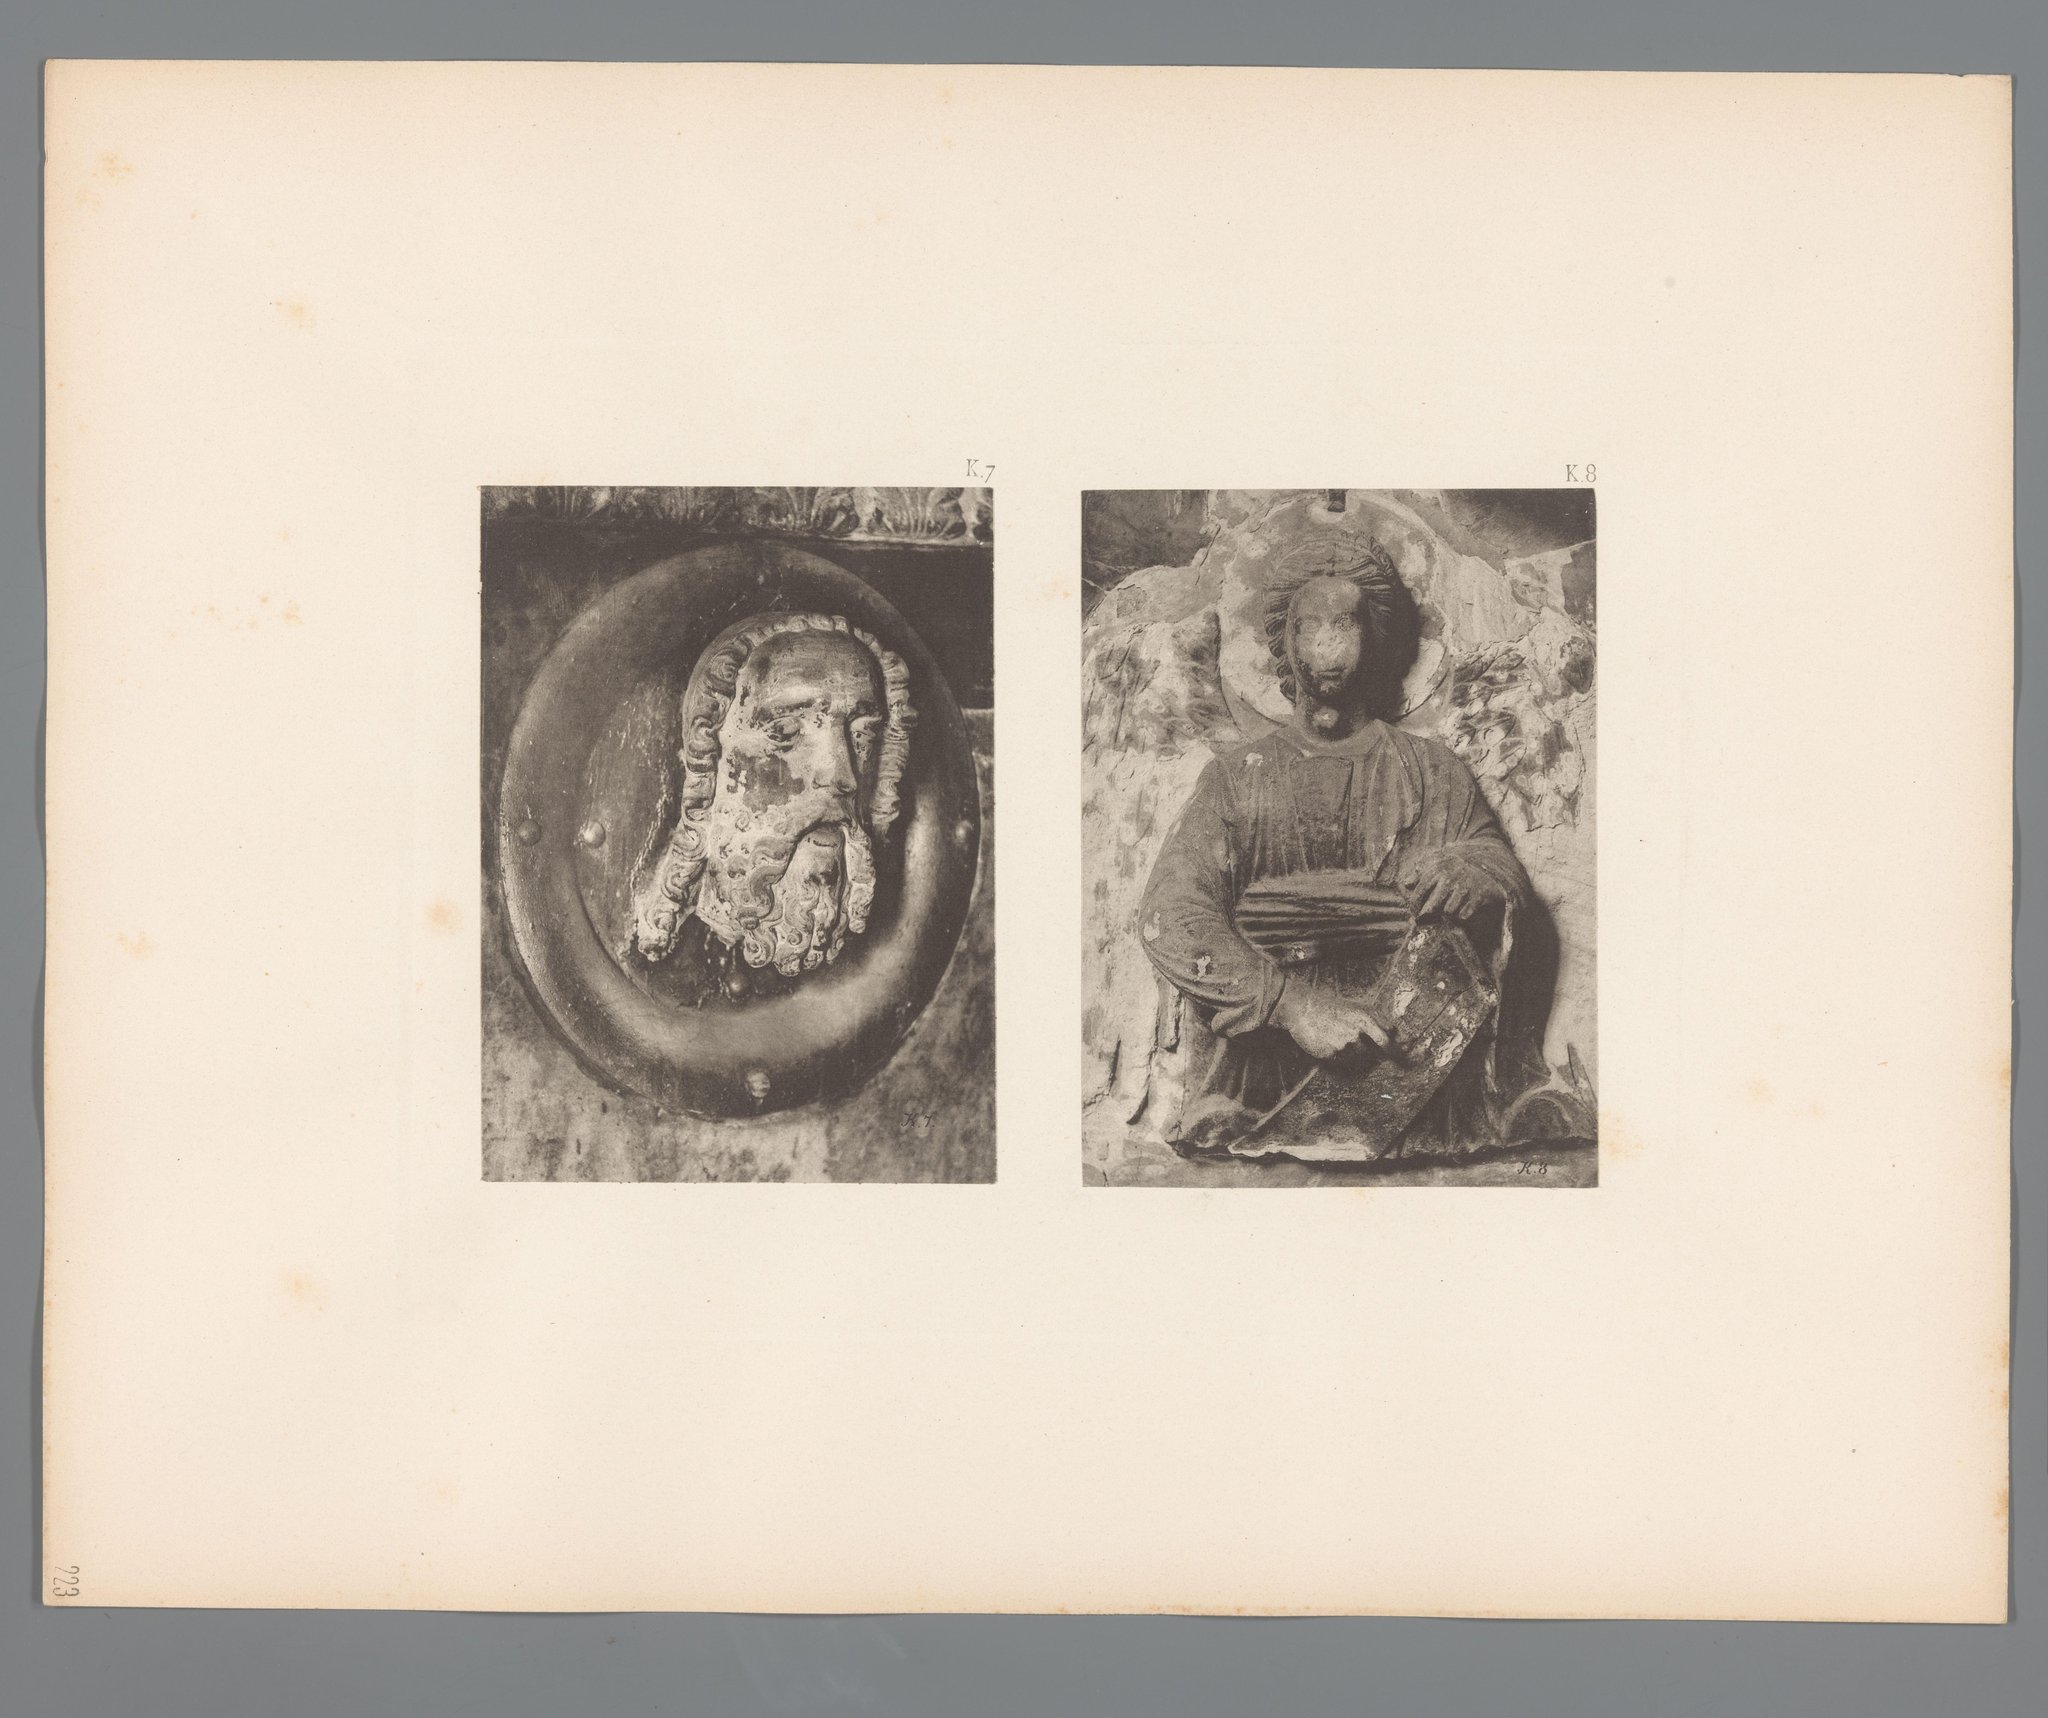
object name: photomechanical print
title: Twee afbeeldingen van sculpturen, waarvan een hoofd van Christus, van de San Marco in Venetië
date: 1880-1885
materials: paper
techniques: photograph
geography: venice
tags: piece of sculpture, reproduction of a piece of sculpture, 'portraits' of christ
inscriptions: number: ‘K.7.’, number: ‘K.8’, number: ‘223’, number: ‘K.8’, number: ‘K.7’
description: Deze prenten maken deel uit van een omslag met 79 prenten op 53 bladen en 2 tekstbladen.